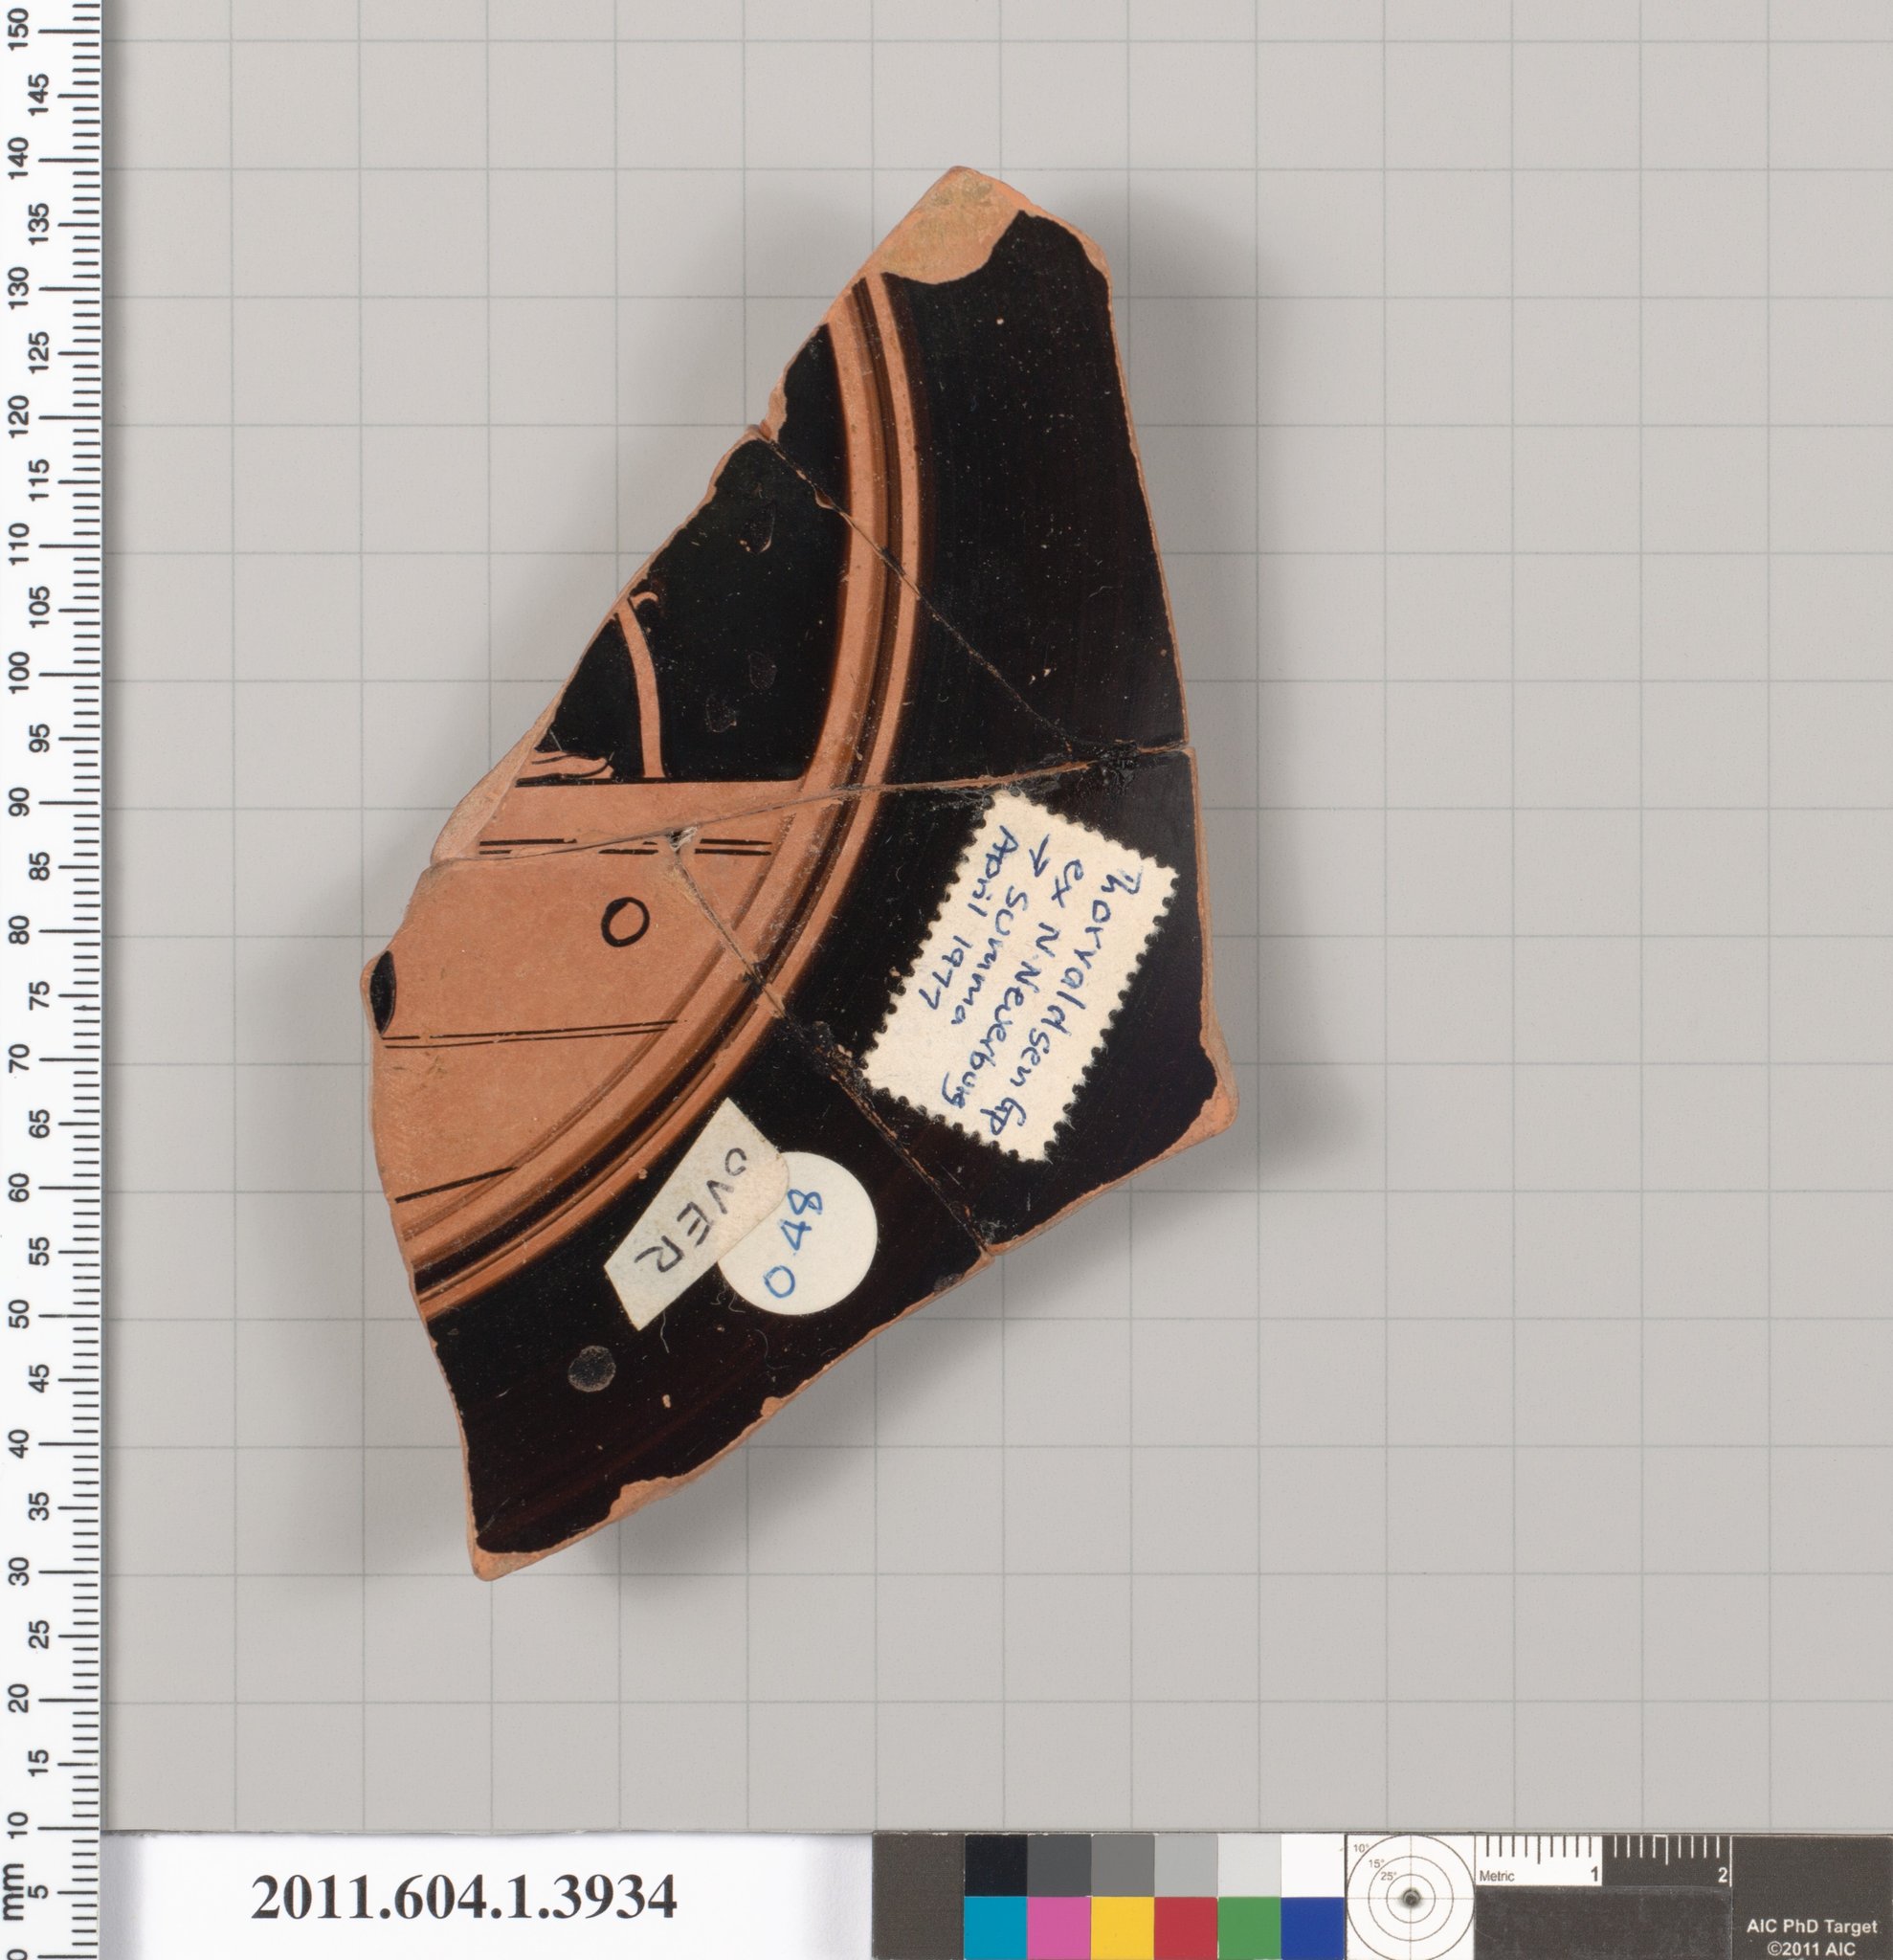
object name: kylix fragment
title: Terracotta fragment of a kylix (drinking cup)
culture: greek, attic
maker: thorvaldsen group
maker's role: artist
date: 500-490 BCE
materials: terracotta